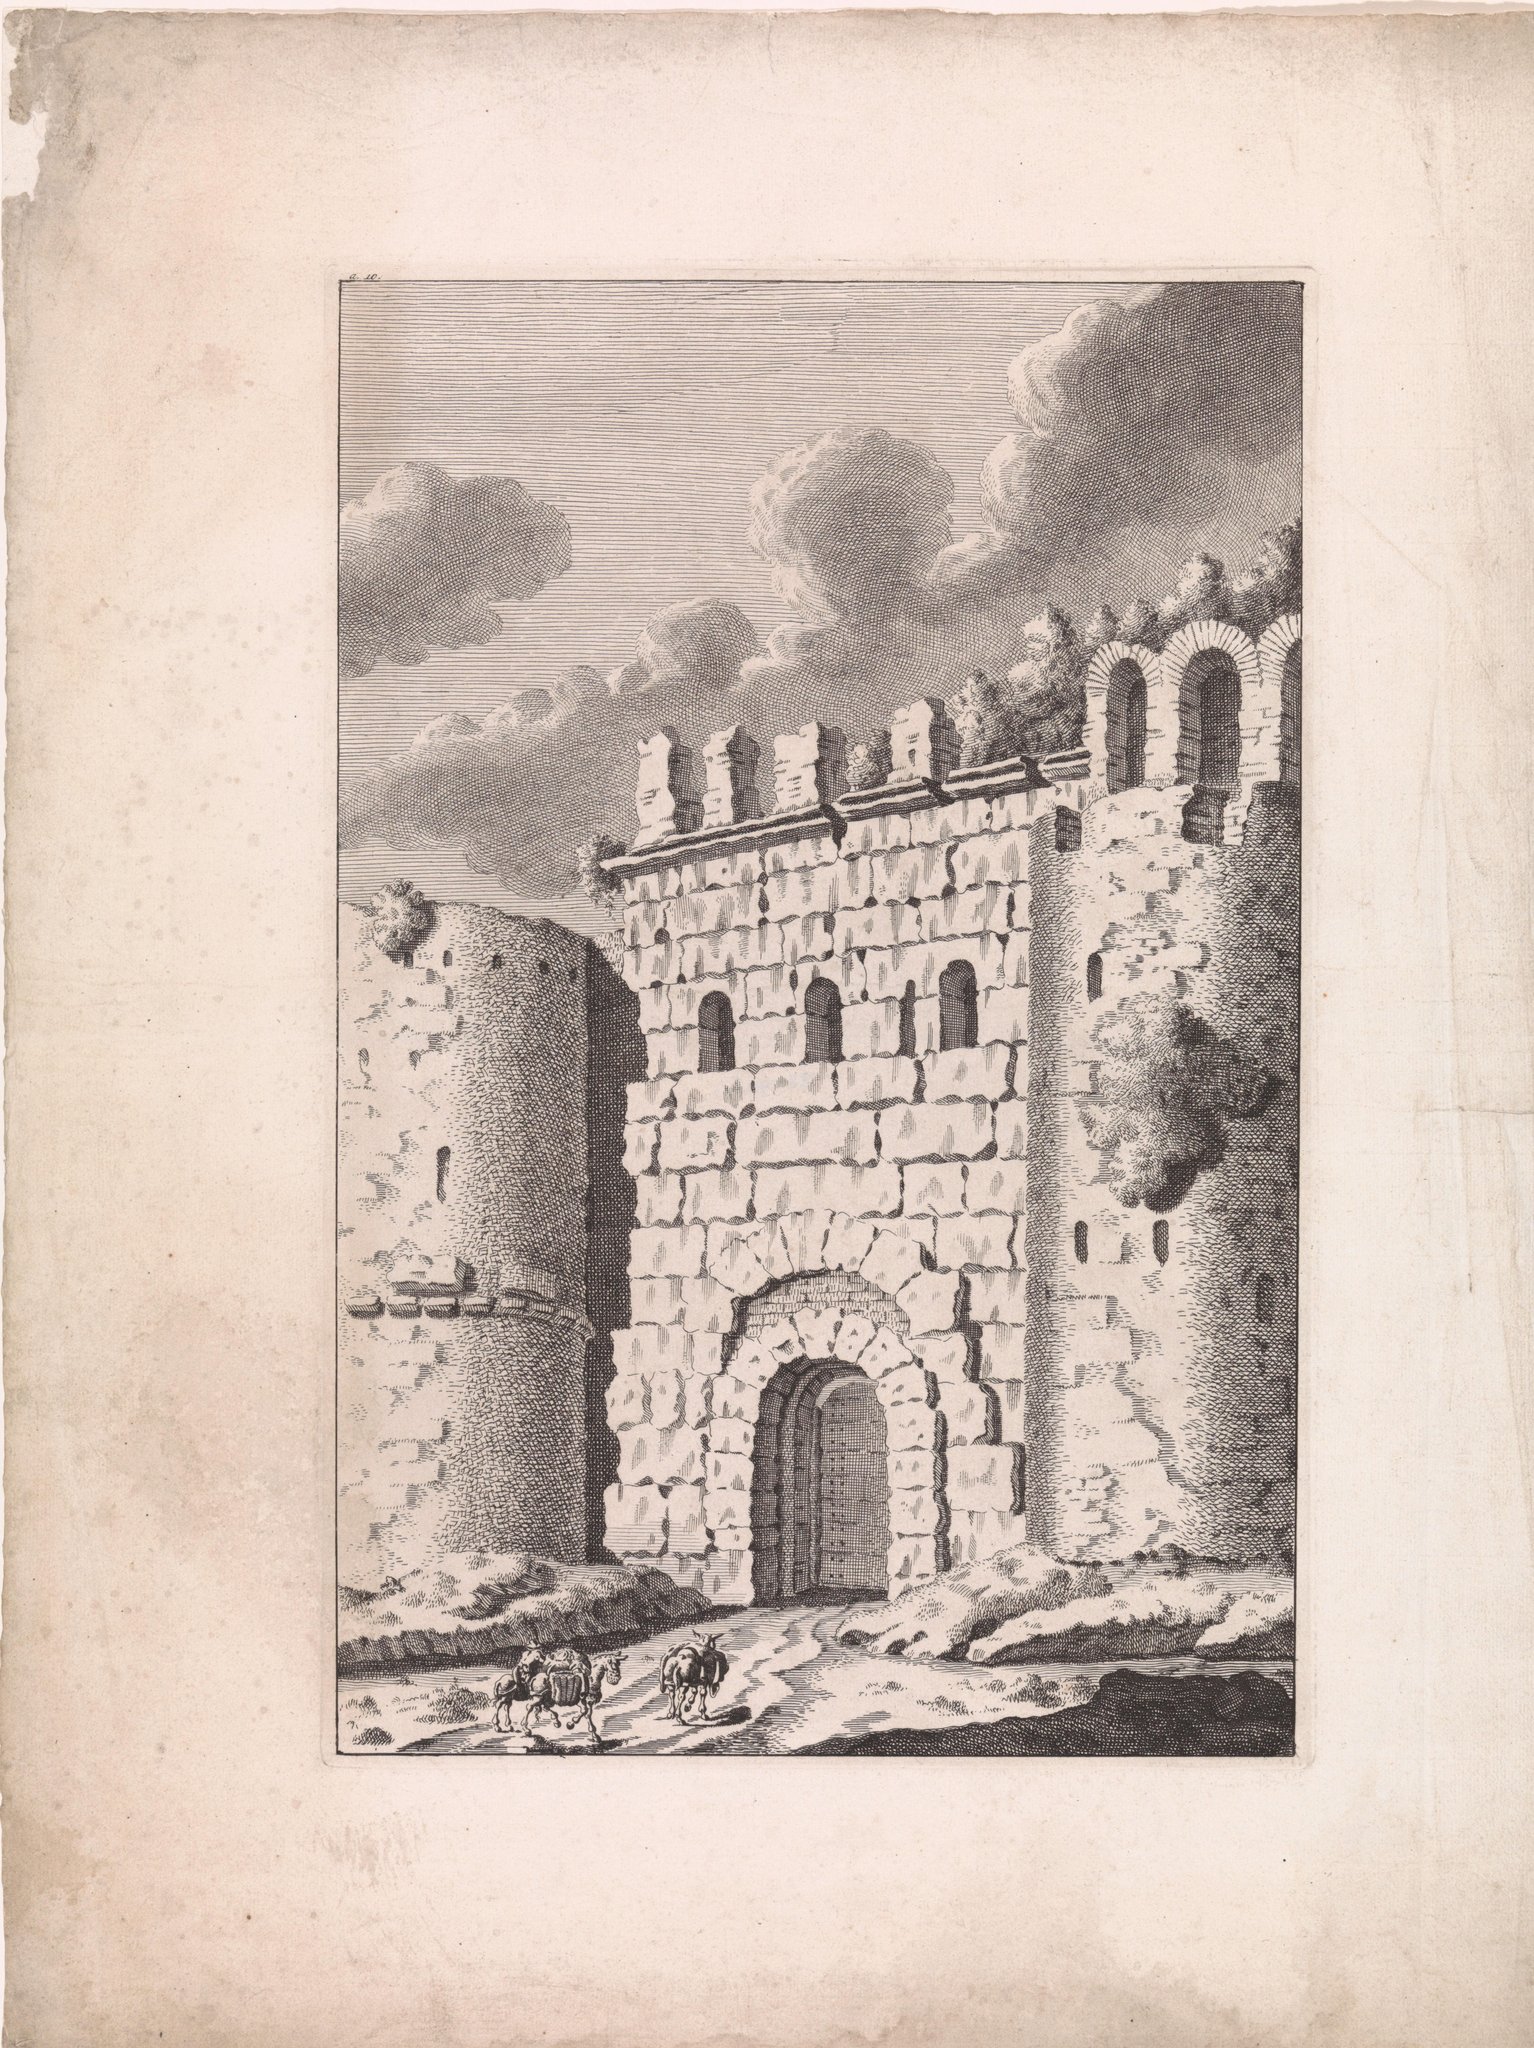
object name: print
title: Reliquiae antiquae urbis Romae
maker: bonaventura van overbeek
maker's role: draughtsman, print maker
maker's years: 1660-1706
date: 1708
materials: paper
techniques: etching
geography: amsterdam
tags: ruin of a building ~ architecture, rome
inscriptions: collector's mark: Lugt 2228